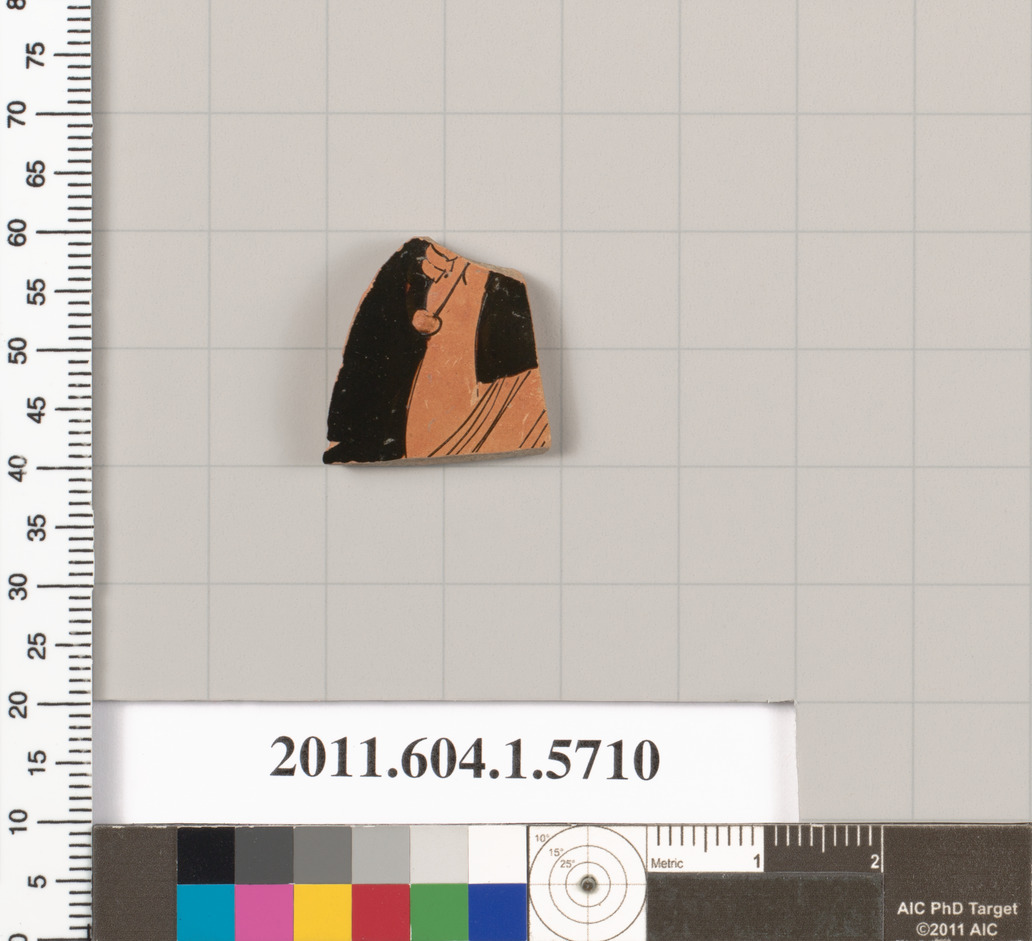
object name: kylix fragment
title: Terracotta fragment of a kylix (drinking cup)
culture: greek, attic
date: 490-480 BCE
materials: terracotta